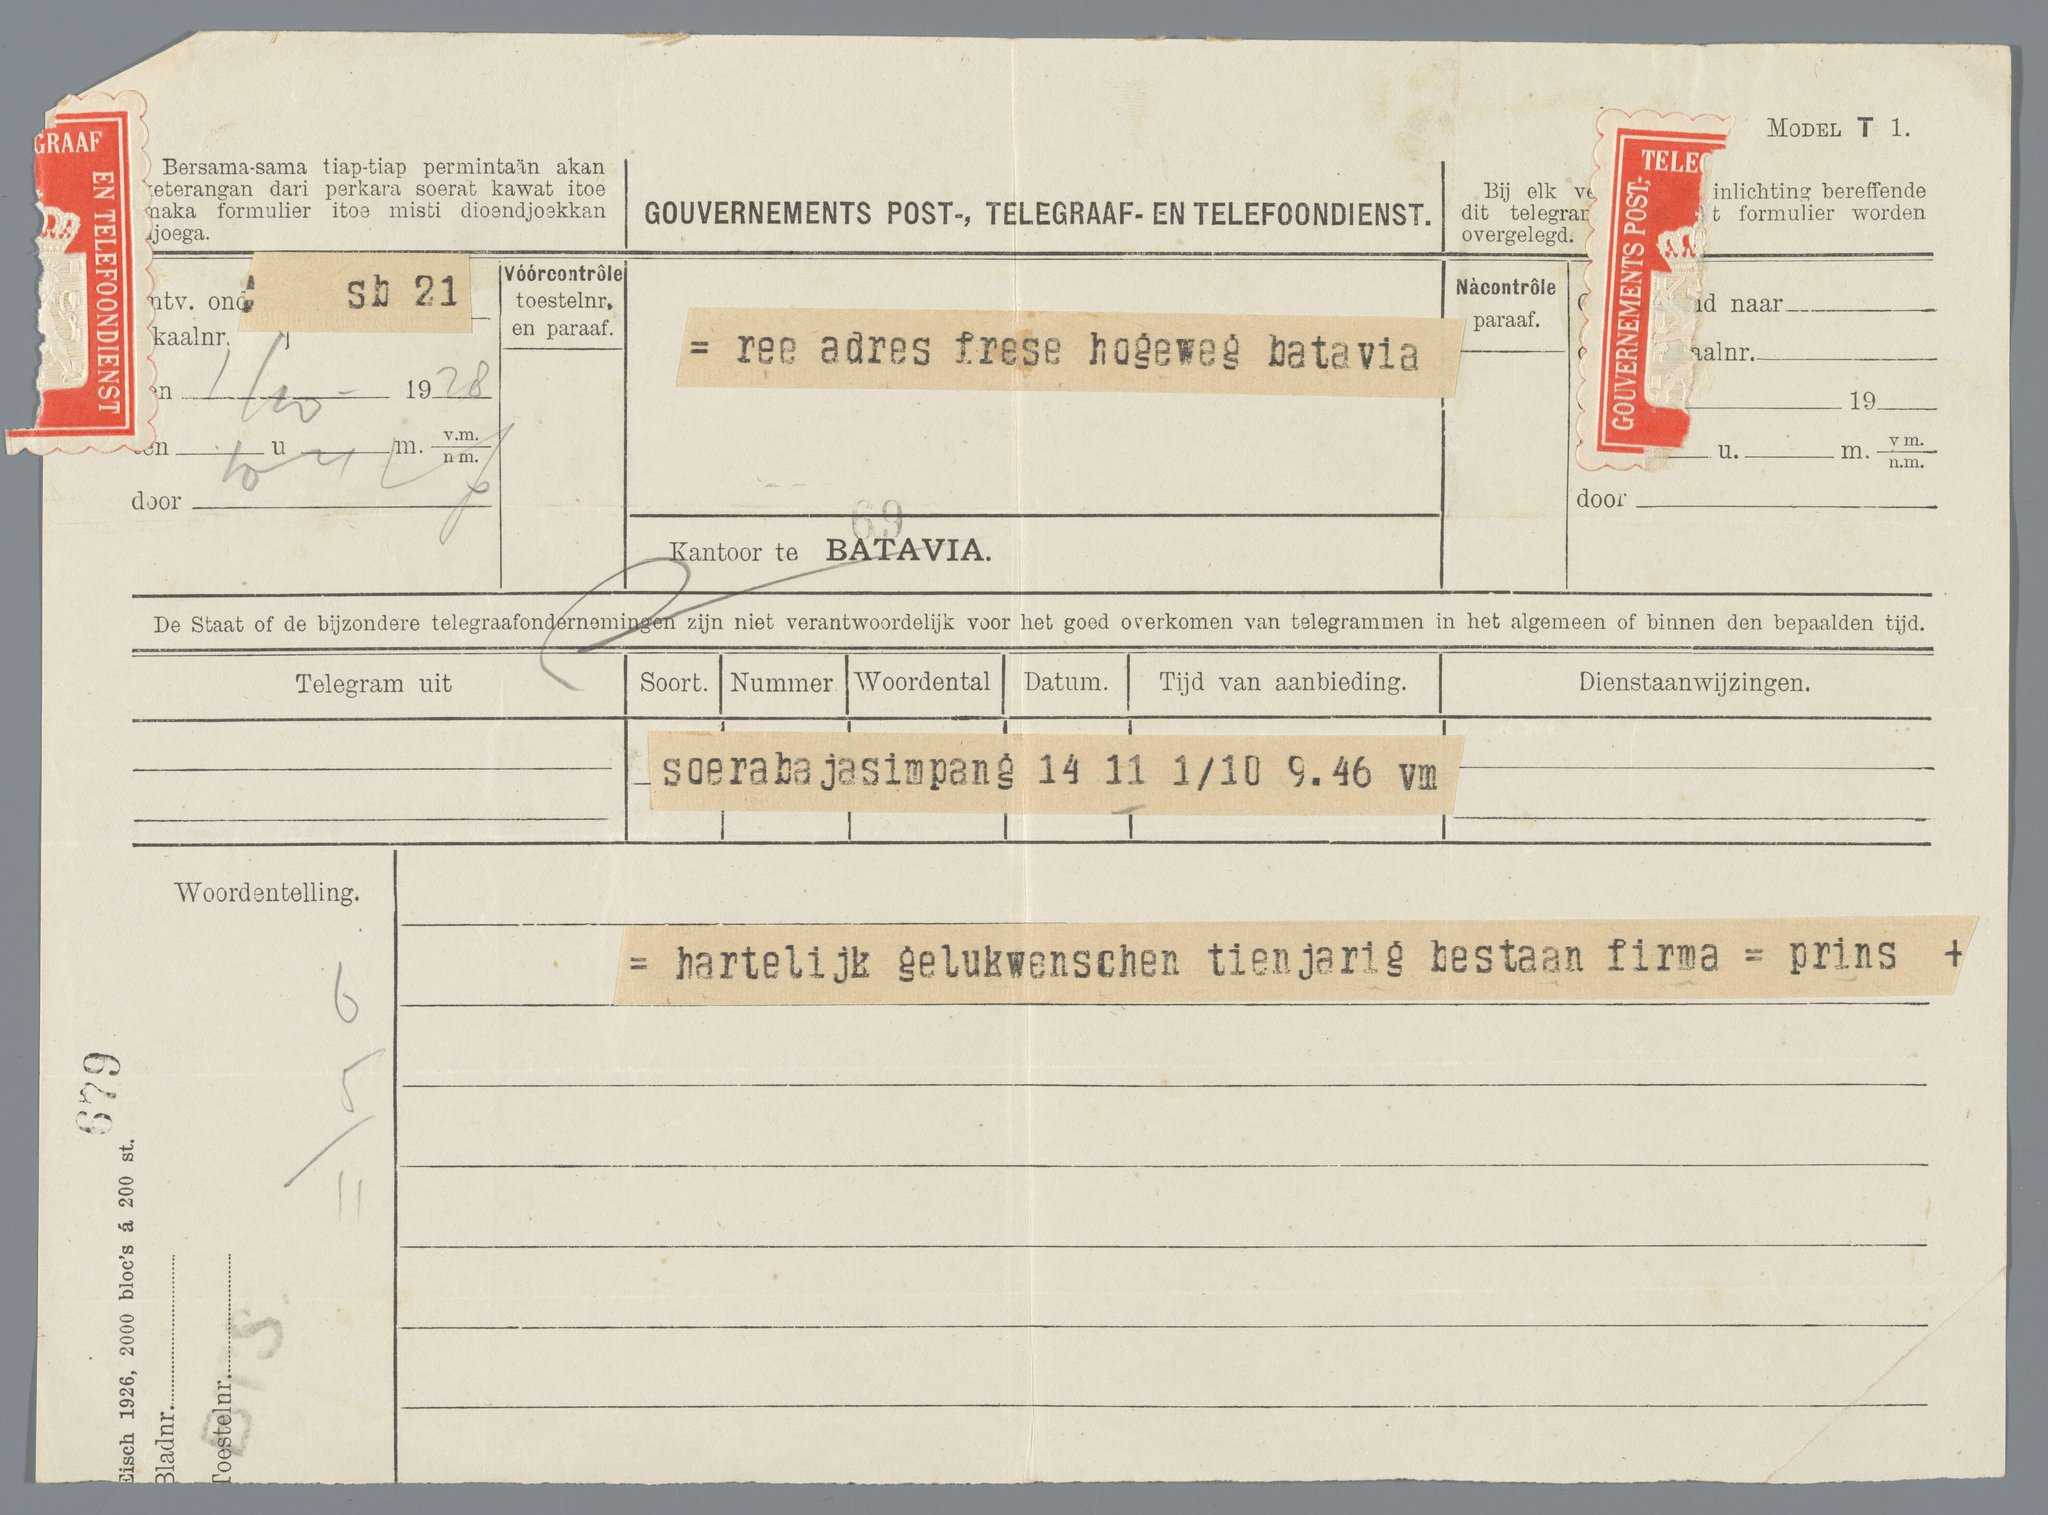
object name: telegram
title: Telegram met gelukwensen, 1928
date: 1928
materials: paper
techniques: typewriting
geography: weltevreden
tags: batavia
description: Telegram met gelukwensen bij het tienjarig bestaan van de firma Frese & Hogeweg, verzonden vanuit Soerabaja op 1 september 1928. Document van Gouvernements Post-, Telegraaf- en Telefoondienst, kantoor Weltevreden, met gedrukte en getypte tekst, stempels en een verbroken zegel. Behoort bij het herinneringsalbum aangeboden aan Willem Ree van accountantsbureau Frese & Hogeweg bij zijn vertrek bij het kantoor in Weltevreden op 30 september 1928.